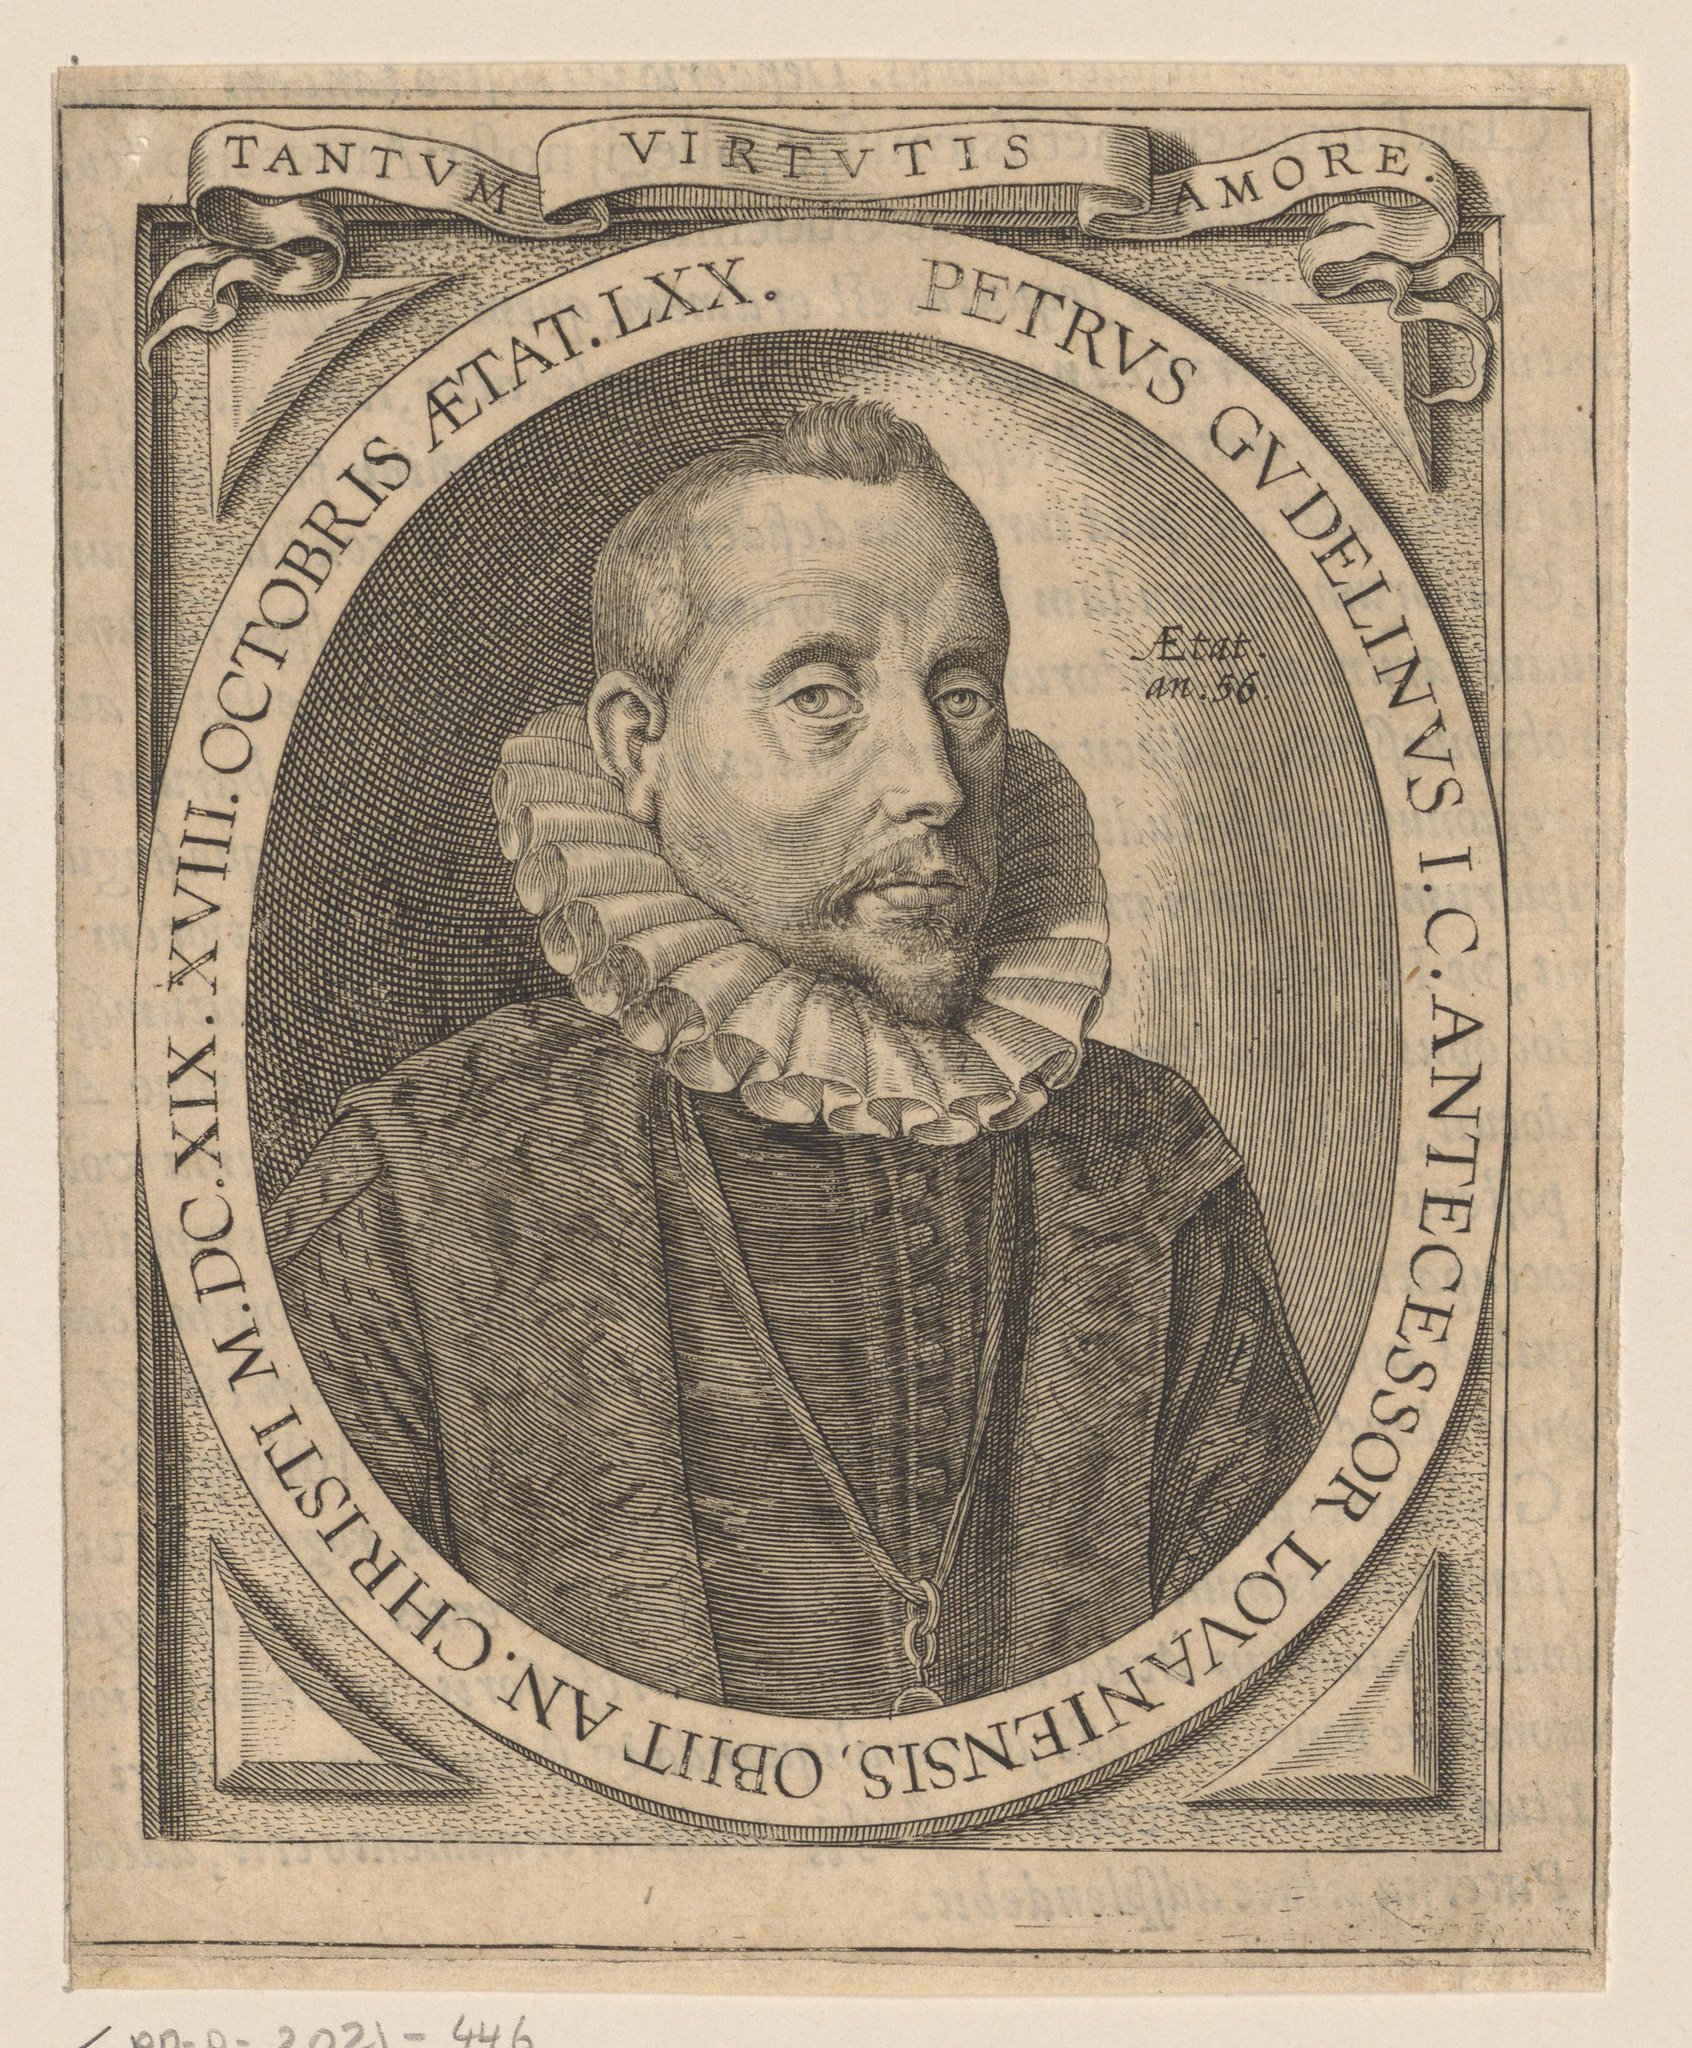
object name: titelblad, titelpagina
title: Titelpagina voor: Petrus Gudelinus, Juris Utriusque Doctoris Academiae Lovaniensis Antecessoris Opera Omnia, 1685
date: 1685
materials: paper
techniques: engraving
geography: antwerp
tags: historical persons, portrait of a writer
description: Titelpagina voor: Gudelinus, Petrus. Juris Utriusque Doctoris, Academiae Lovaniensis Antecessoris Opera Omnia (...). Antwerpen: Hieronymus Verdussen, 1685.